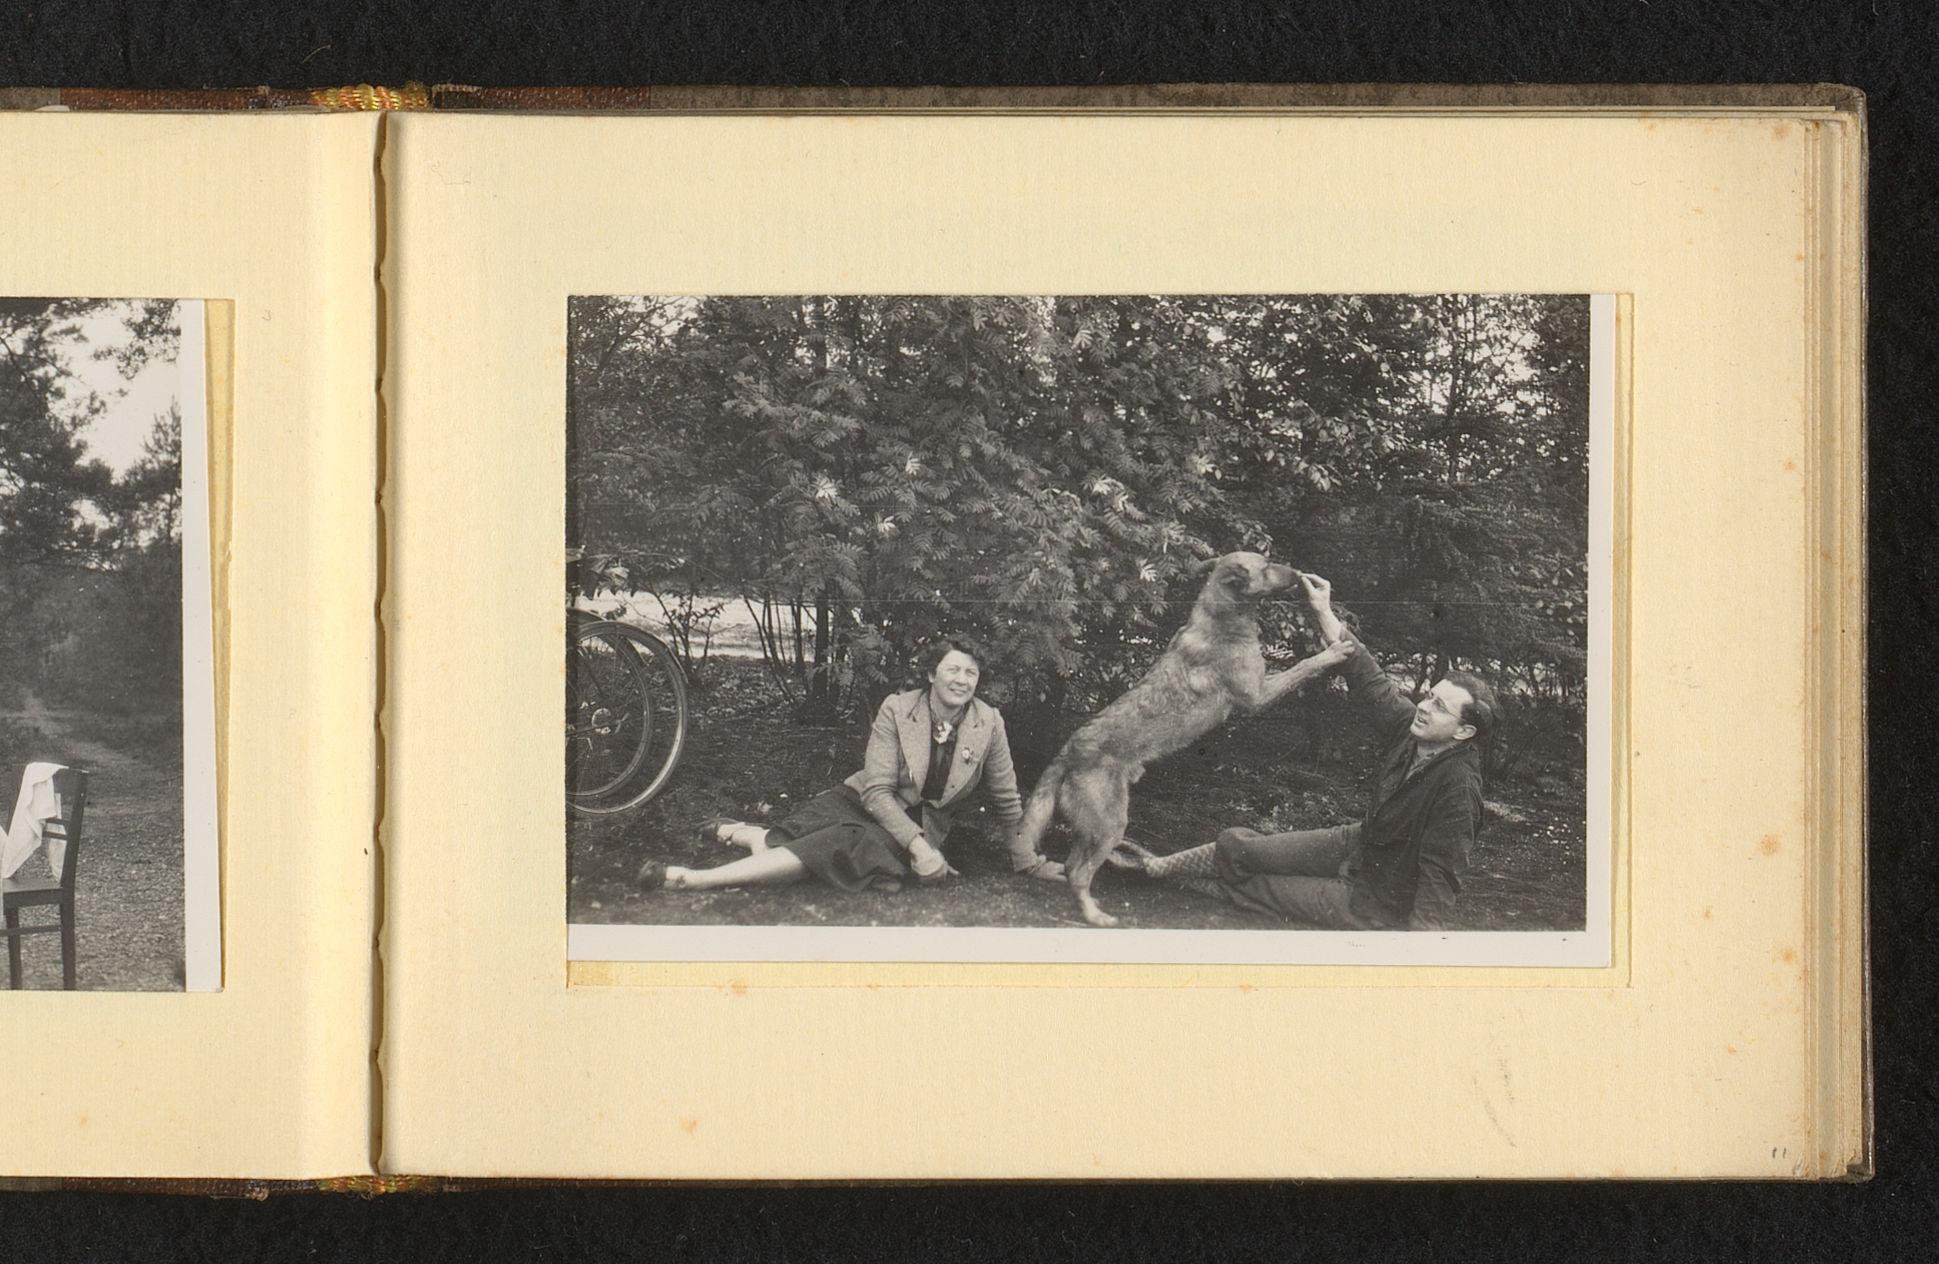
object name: photograph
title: Vrouw en man zittend op de grond, spelend met hond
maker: norbert van den berg (1901-1972)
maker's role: amateurfotograaf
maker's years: 1901-1972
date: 1935-1950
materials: paper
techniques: gelatin silver print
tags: adult woman, adult man, sitting on the ground, dog